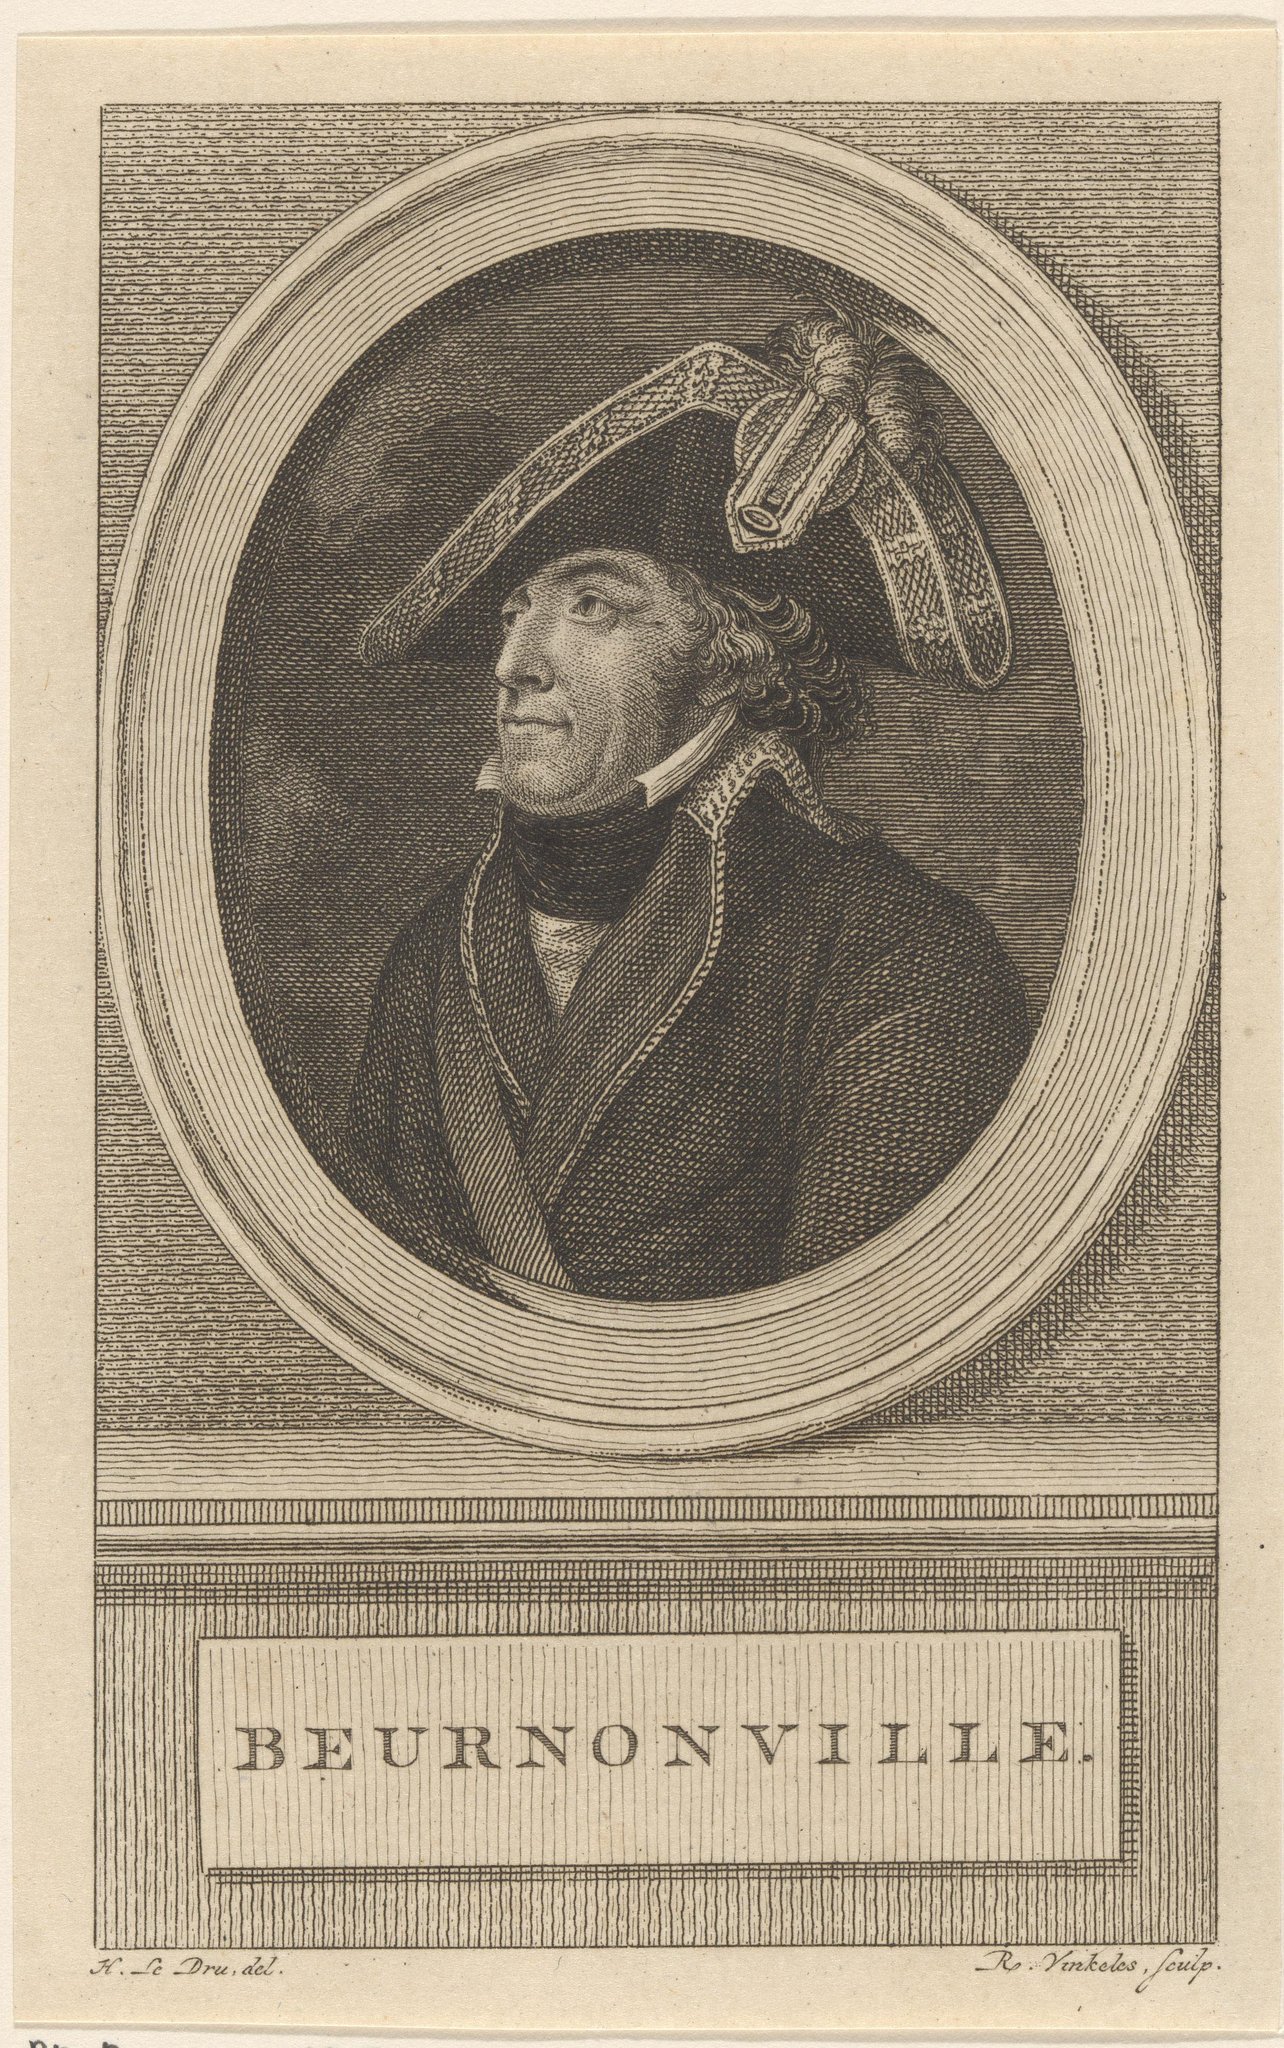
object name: print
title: Portret van Pierre de Riël de Beurnonville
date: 1793-1816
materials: paper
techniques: engraving, etching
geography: amsterdam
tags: paris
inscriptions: collector's mark: Lugt 2228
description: Portret van Pierre de Riël de Beurnonville, minister van oorlog in Frankrijk.